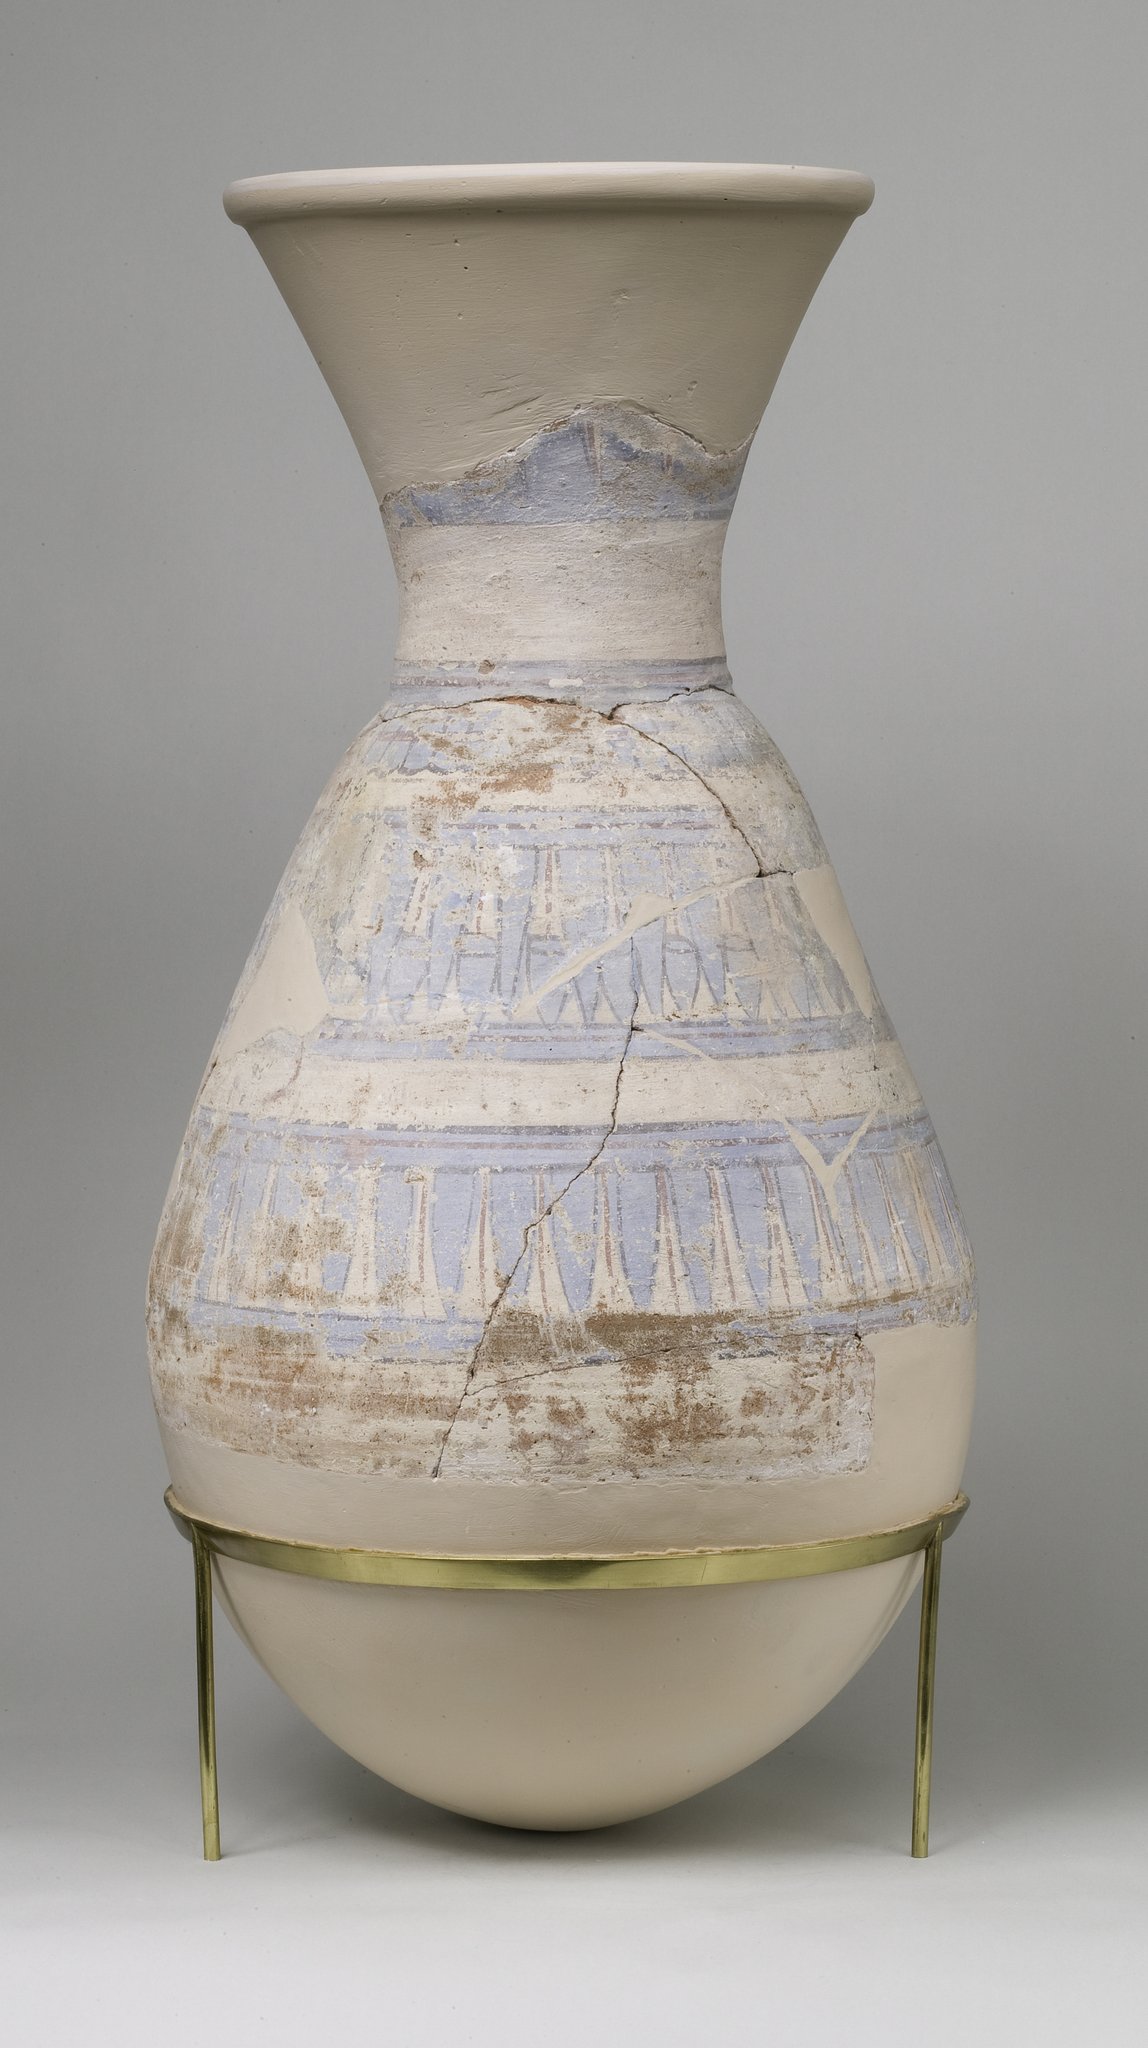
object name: jar, blue painted, malqata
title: Blue-Painted Jar from Malqata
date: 1390-1352 BCE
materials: paint, pottery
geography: egypt